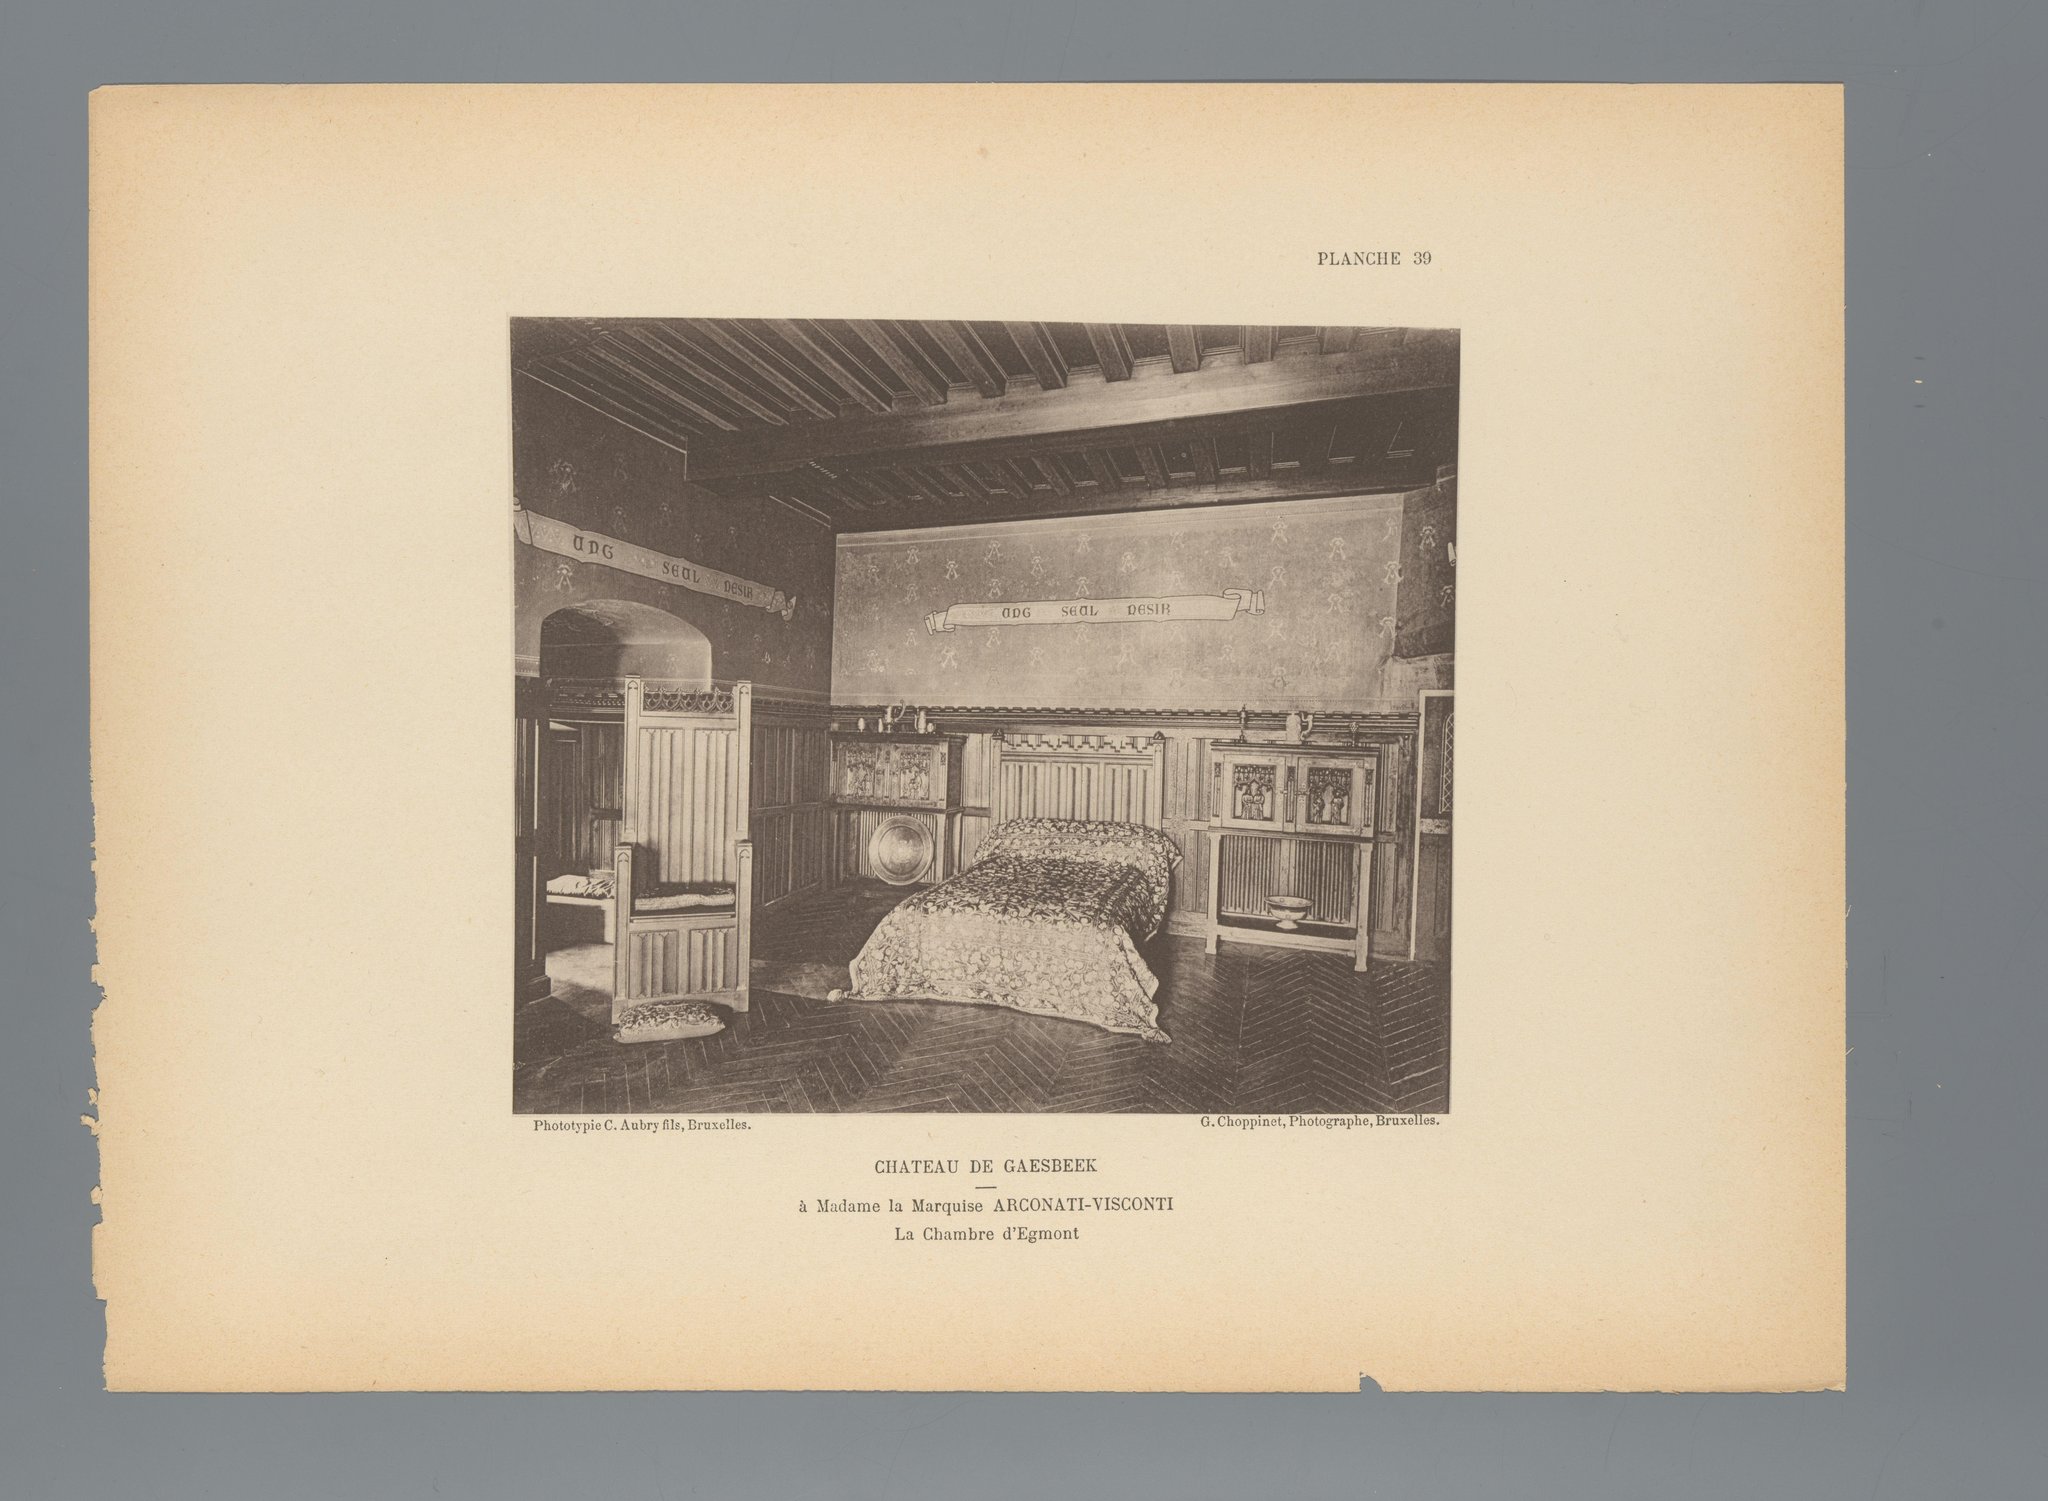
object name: photomechanical print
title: Gezicht op de slaapkamer van Lamoraal van Egmont in het Kasteel van Gaasbeek, België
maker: gustave choppinet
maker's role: fotograaf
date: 1893-1898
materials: paper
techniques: photograph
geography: kasteel van gaasbeek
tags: castle, bedroom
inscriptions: inscription: ‘à Madame la Marquise ARCONATI-VISCONTI/ La Chambre d'Egmont’, number: ‘PLANCHE 39’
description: Deze prent maakt deel uit van een omslag met 89 prenten en 5 tekstbladen.